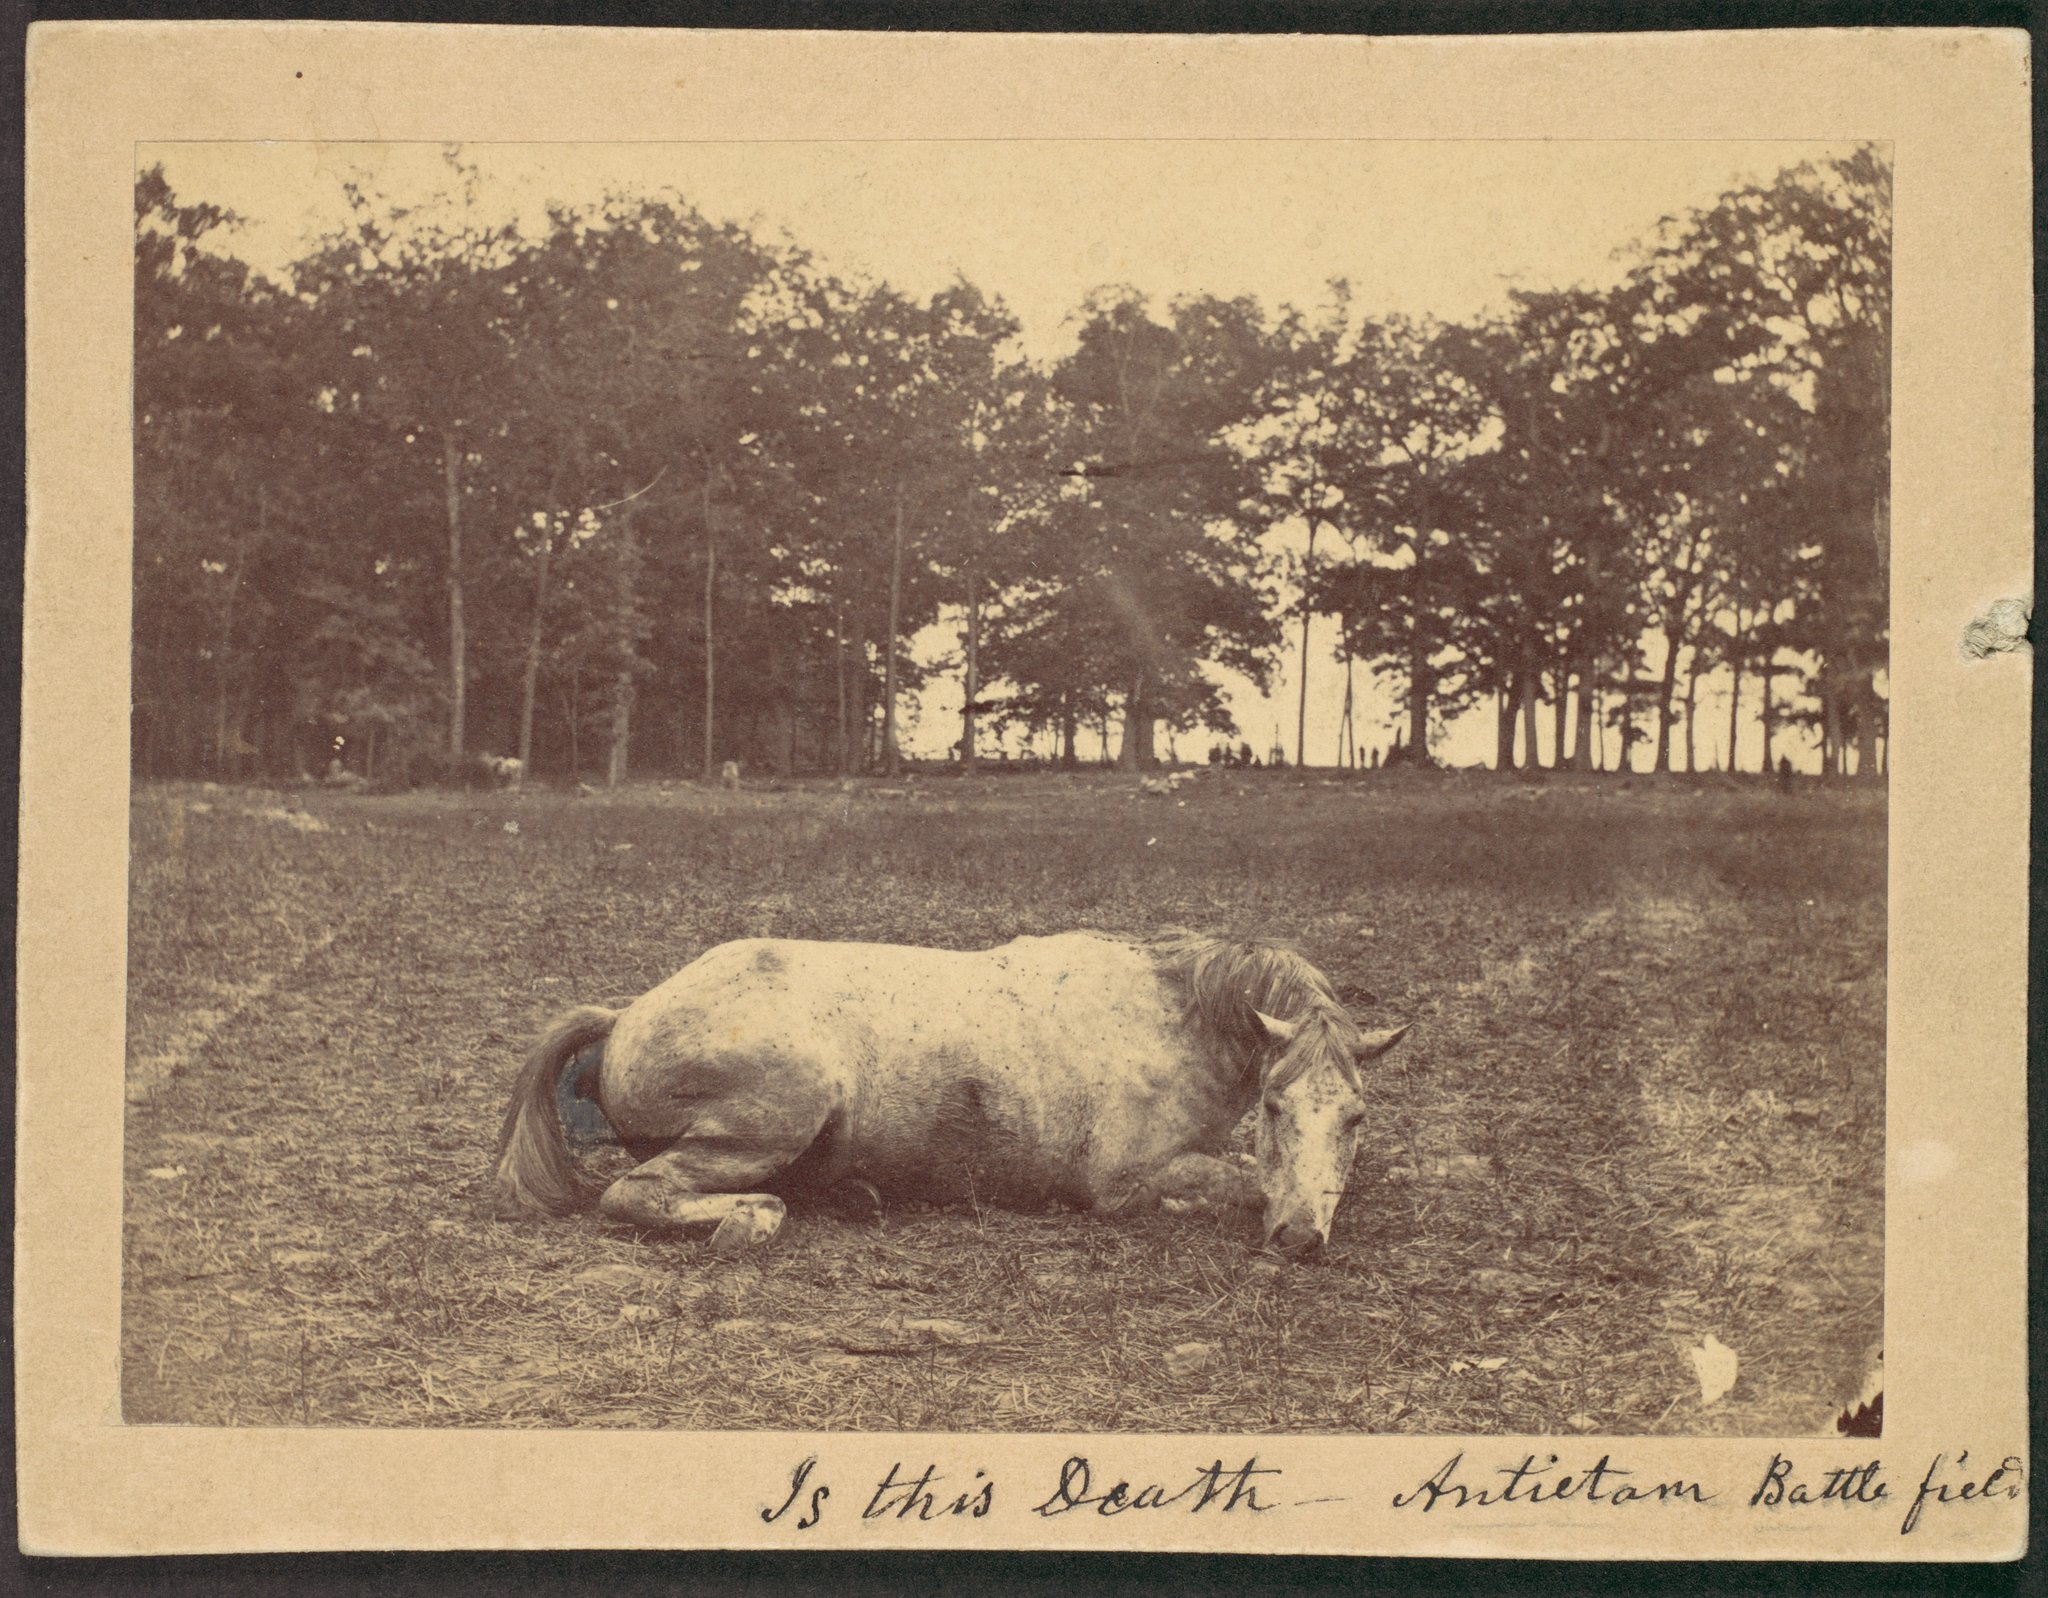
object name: photograph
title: Is This Death - Antietam Battlefield, September 1862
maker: alexander gardner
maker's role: artist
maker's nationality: american, scottish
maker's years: 1821-1882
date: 1862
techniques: albumen silver print, glass negative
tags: american civil war,horses